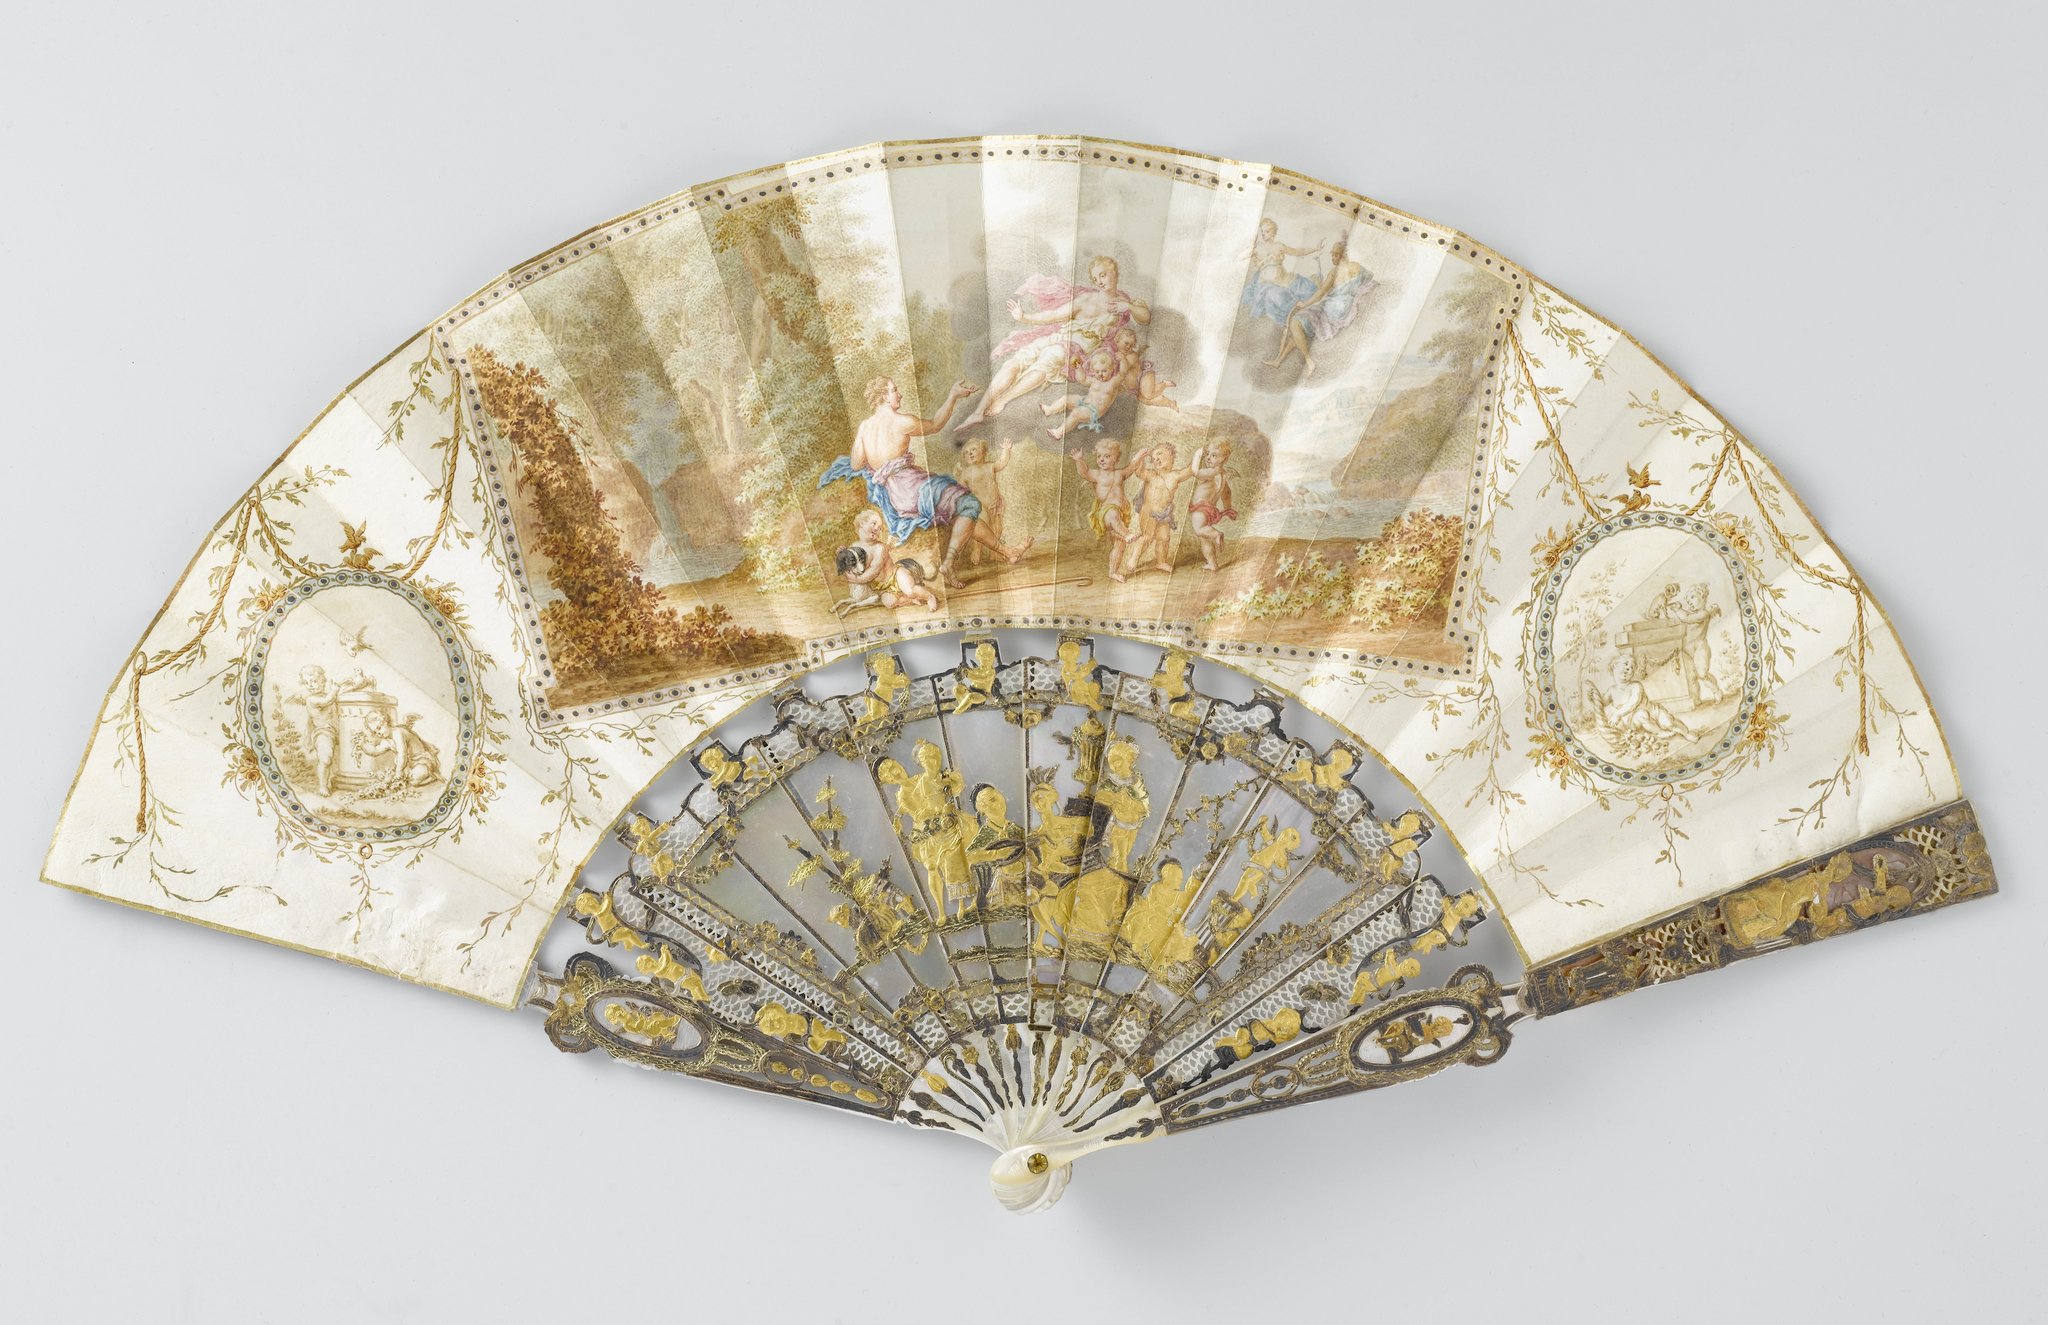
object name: vouwwaaier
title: Vouwwaaier met blad van papier waarop in gouache 'Het Oordeel van Paris', op een montuur van parelmoer ajour en in reliëf gesneden met 'métal en quatre couleur'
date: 1780-1790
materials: glass, gouache, mother of pearl, paint, paper, wood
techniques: embroidery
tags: the judgement of paris (without mercury)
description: Vouwwaaier met blad van papier waarop in gouache 'Het Oordeel van Paris', op een montuur van parelmoer ajour en in reliëf gesneden met 'métal en quatre couleur'. In het bijzonder fijn geschilderde, centrale veld wijst de koningszoon en herder Paris de godin Aphrodite aan als winnares van de schoonheidswedstrijd die tussen haar en de godinnen Athena en Hera was gestreden. Hera met de pauw en Athena met helm en schild kijken vanaf een wolk in de verte toe. Het verhaal over 'Het oordeel van Paris' dat in de 1e eeuw na Chr. door Lucianus van Samosata (ca. 120-180 n. Chr.) te boek was gesteld, werd in de loop van de 16e, 17e en 18e eeuw vele malen in Nederlandse vertalingen uitgegeven. Bij Van Mander (1548-1606), Krul (1601/2-1646) en Poot (1689-1733) kreeg het een moraliserende toon en was Paris een lichtzinnige jongeman, die de voorkeur gaf aan de zinnelijke genoegens (Aphrodite) boven de wijsheid (Athena) en de macht (Hera). In een andere interpretatie werd het verhaal gebruikt als lofprijzing op de vrouw die alle kwaliteiten, waaruit Paris moest kiezen, in zich verenigde. Het lijkt alsof de medaillons links en rechts aan gedraaide koorden zijn opgehangen, die verder door ringen langs de rand van het blad afhangen. Boven op de omlijsting van deze medaillons, waarin verschillende huwelijkssymbolen, zoals een huwelijksaltaar met twee tortelduiven en een hondje, zitten twee tortelende duiven. In de schildering op de achterkant keren deze motieven terug. Het montuur wordt bijna geheel gevuld door een galante partij met verstrengelde liefdesparen, muzikanten en zangers omgeven door putti met bloemslingers. In een ovaal op het rechter buitenbeen een putto met een open muizenval.